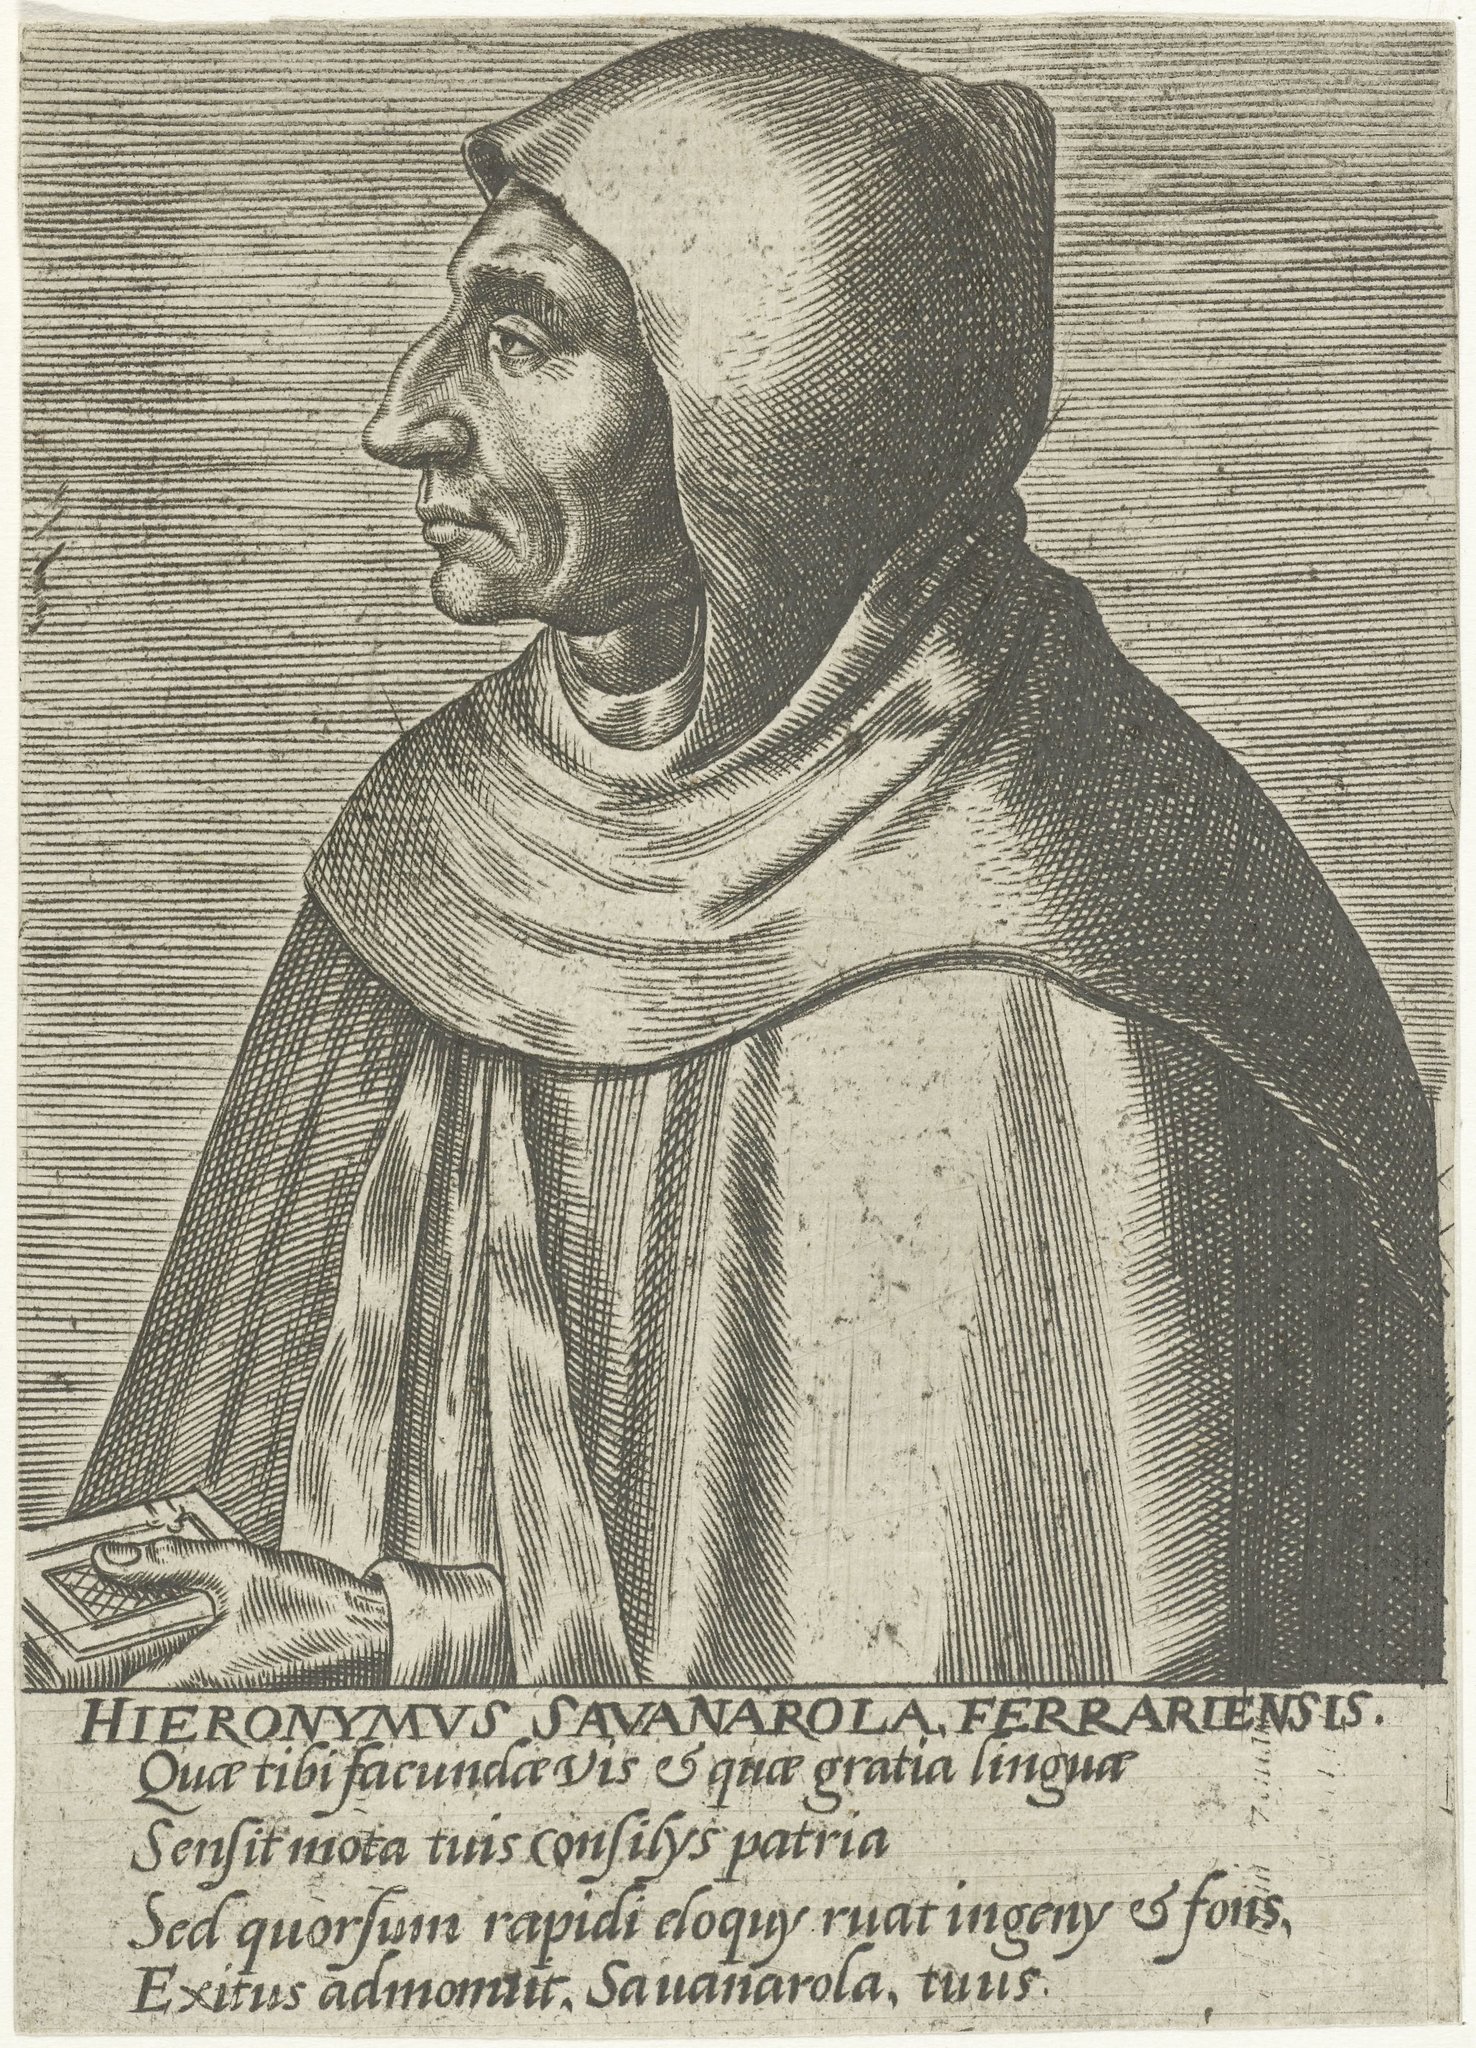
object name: print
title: Hieronymvs Savonarola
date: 1572-1662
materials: paper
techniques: engraving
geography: antwerp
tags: priest, politician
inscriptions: collector's mark: Lugt 2228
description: Portret van Girolamo Savonarola, Italiaanse Dominicaner monnik. Buste naar links. De prent heeft een Latijns onderschrift en maakt deel uit van een serie van beroemde Europese geleerden.